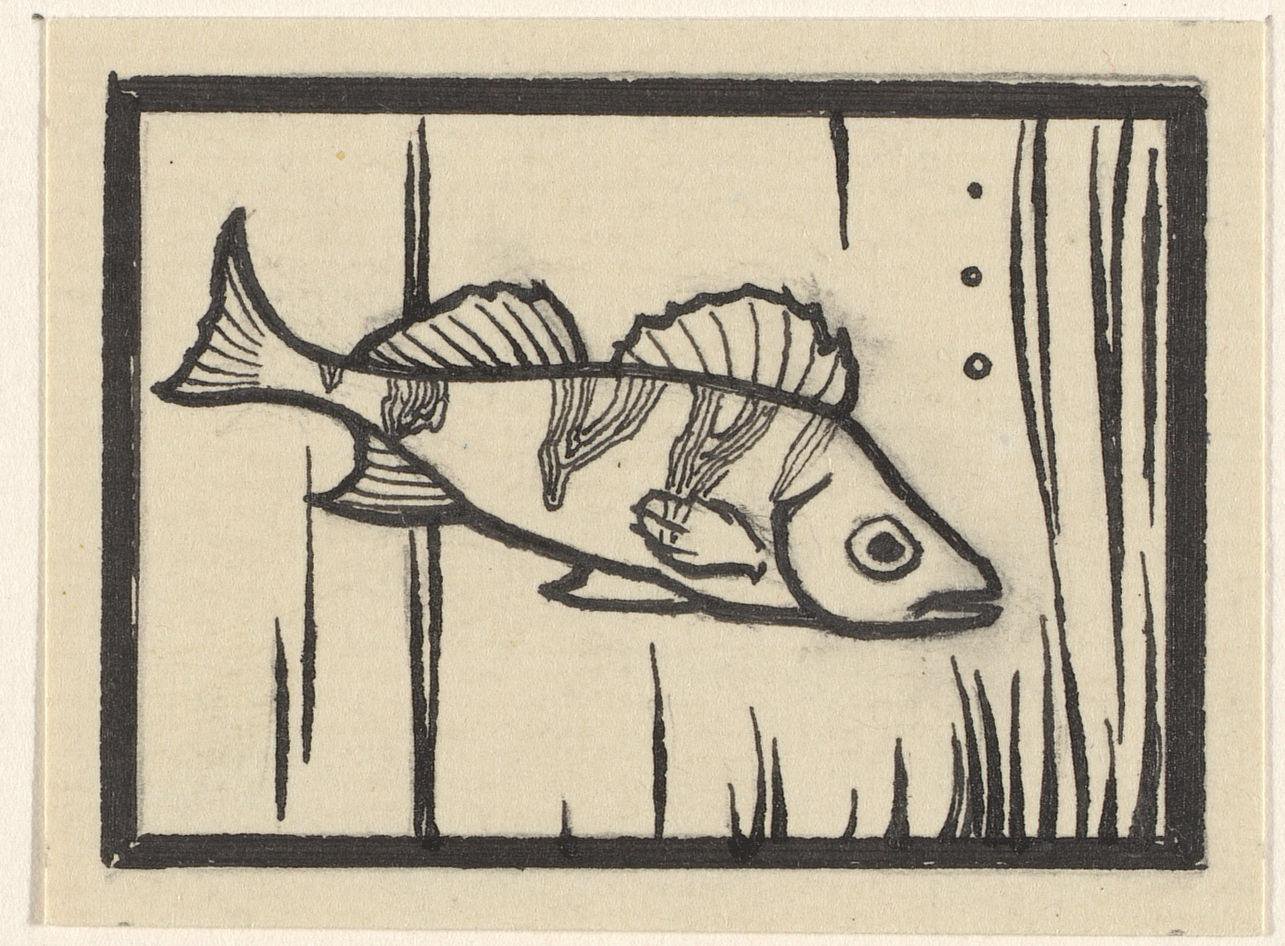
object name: drawing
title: Vis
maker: julie de graag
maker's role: draughtsman, print maker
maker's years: 1877-1924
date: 1887-1924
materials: ink, paper, pencil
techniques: pen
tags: fishes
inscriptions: number: ‘64’